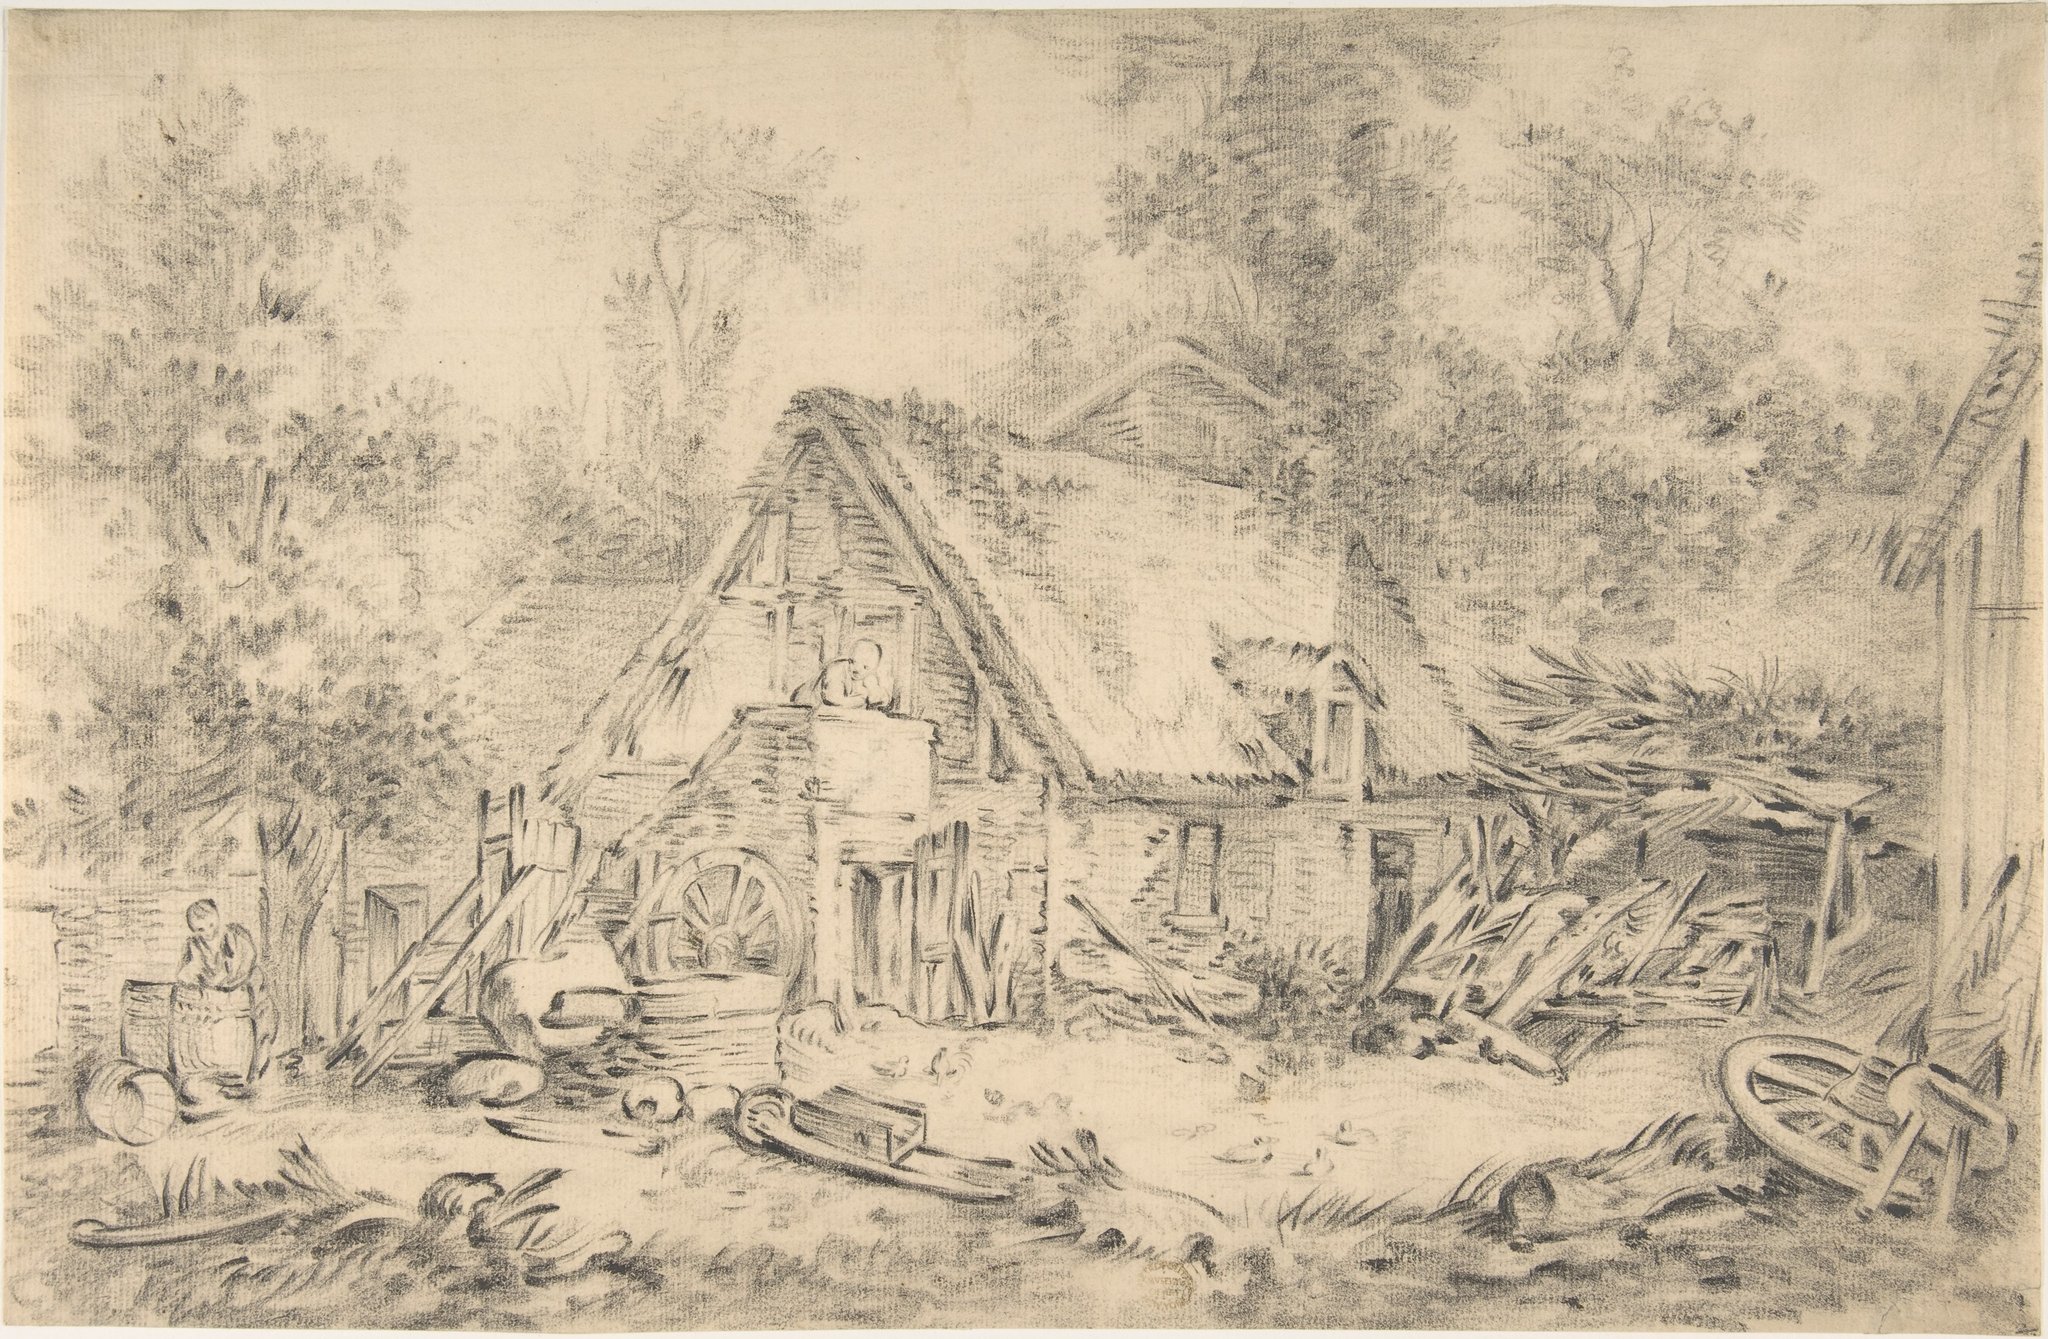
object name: drawing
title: A Cottage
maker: françois boucher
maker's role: artist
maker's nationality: french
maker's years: 1703-1770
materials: chalk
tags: human figures,houses,trees